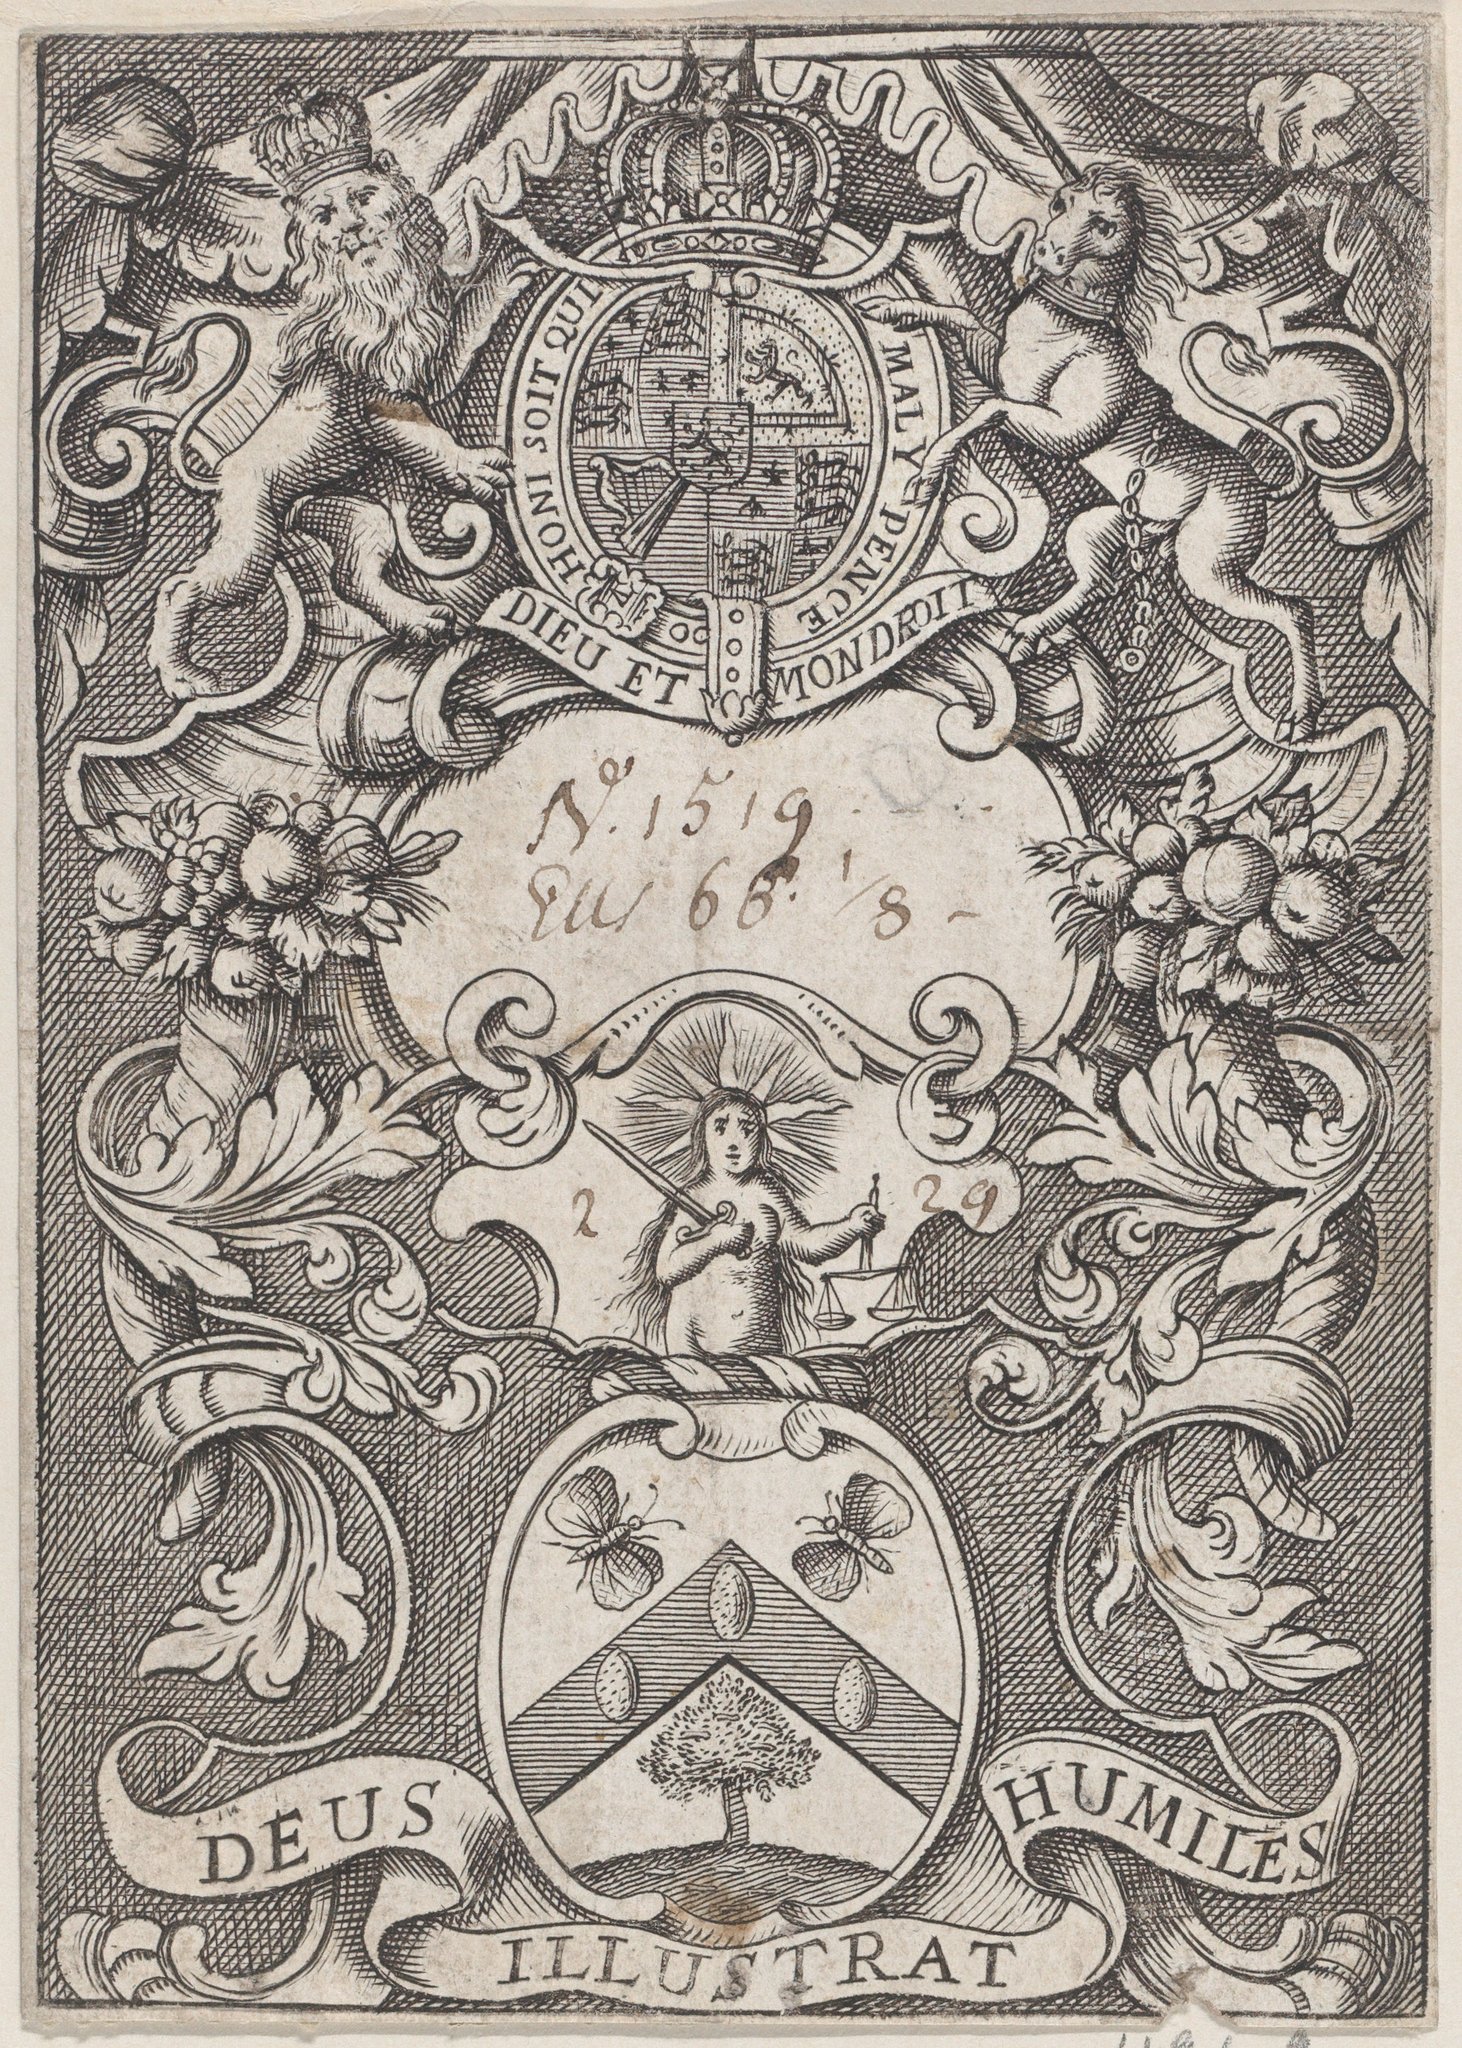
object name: print, trade card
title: Trade Card with Royal Coat of Arms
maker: anonymous, british, 19th century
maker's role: artist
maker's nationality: british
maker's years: 1800-1900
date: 1801-1900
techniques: engraving